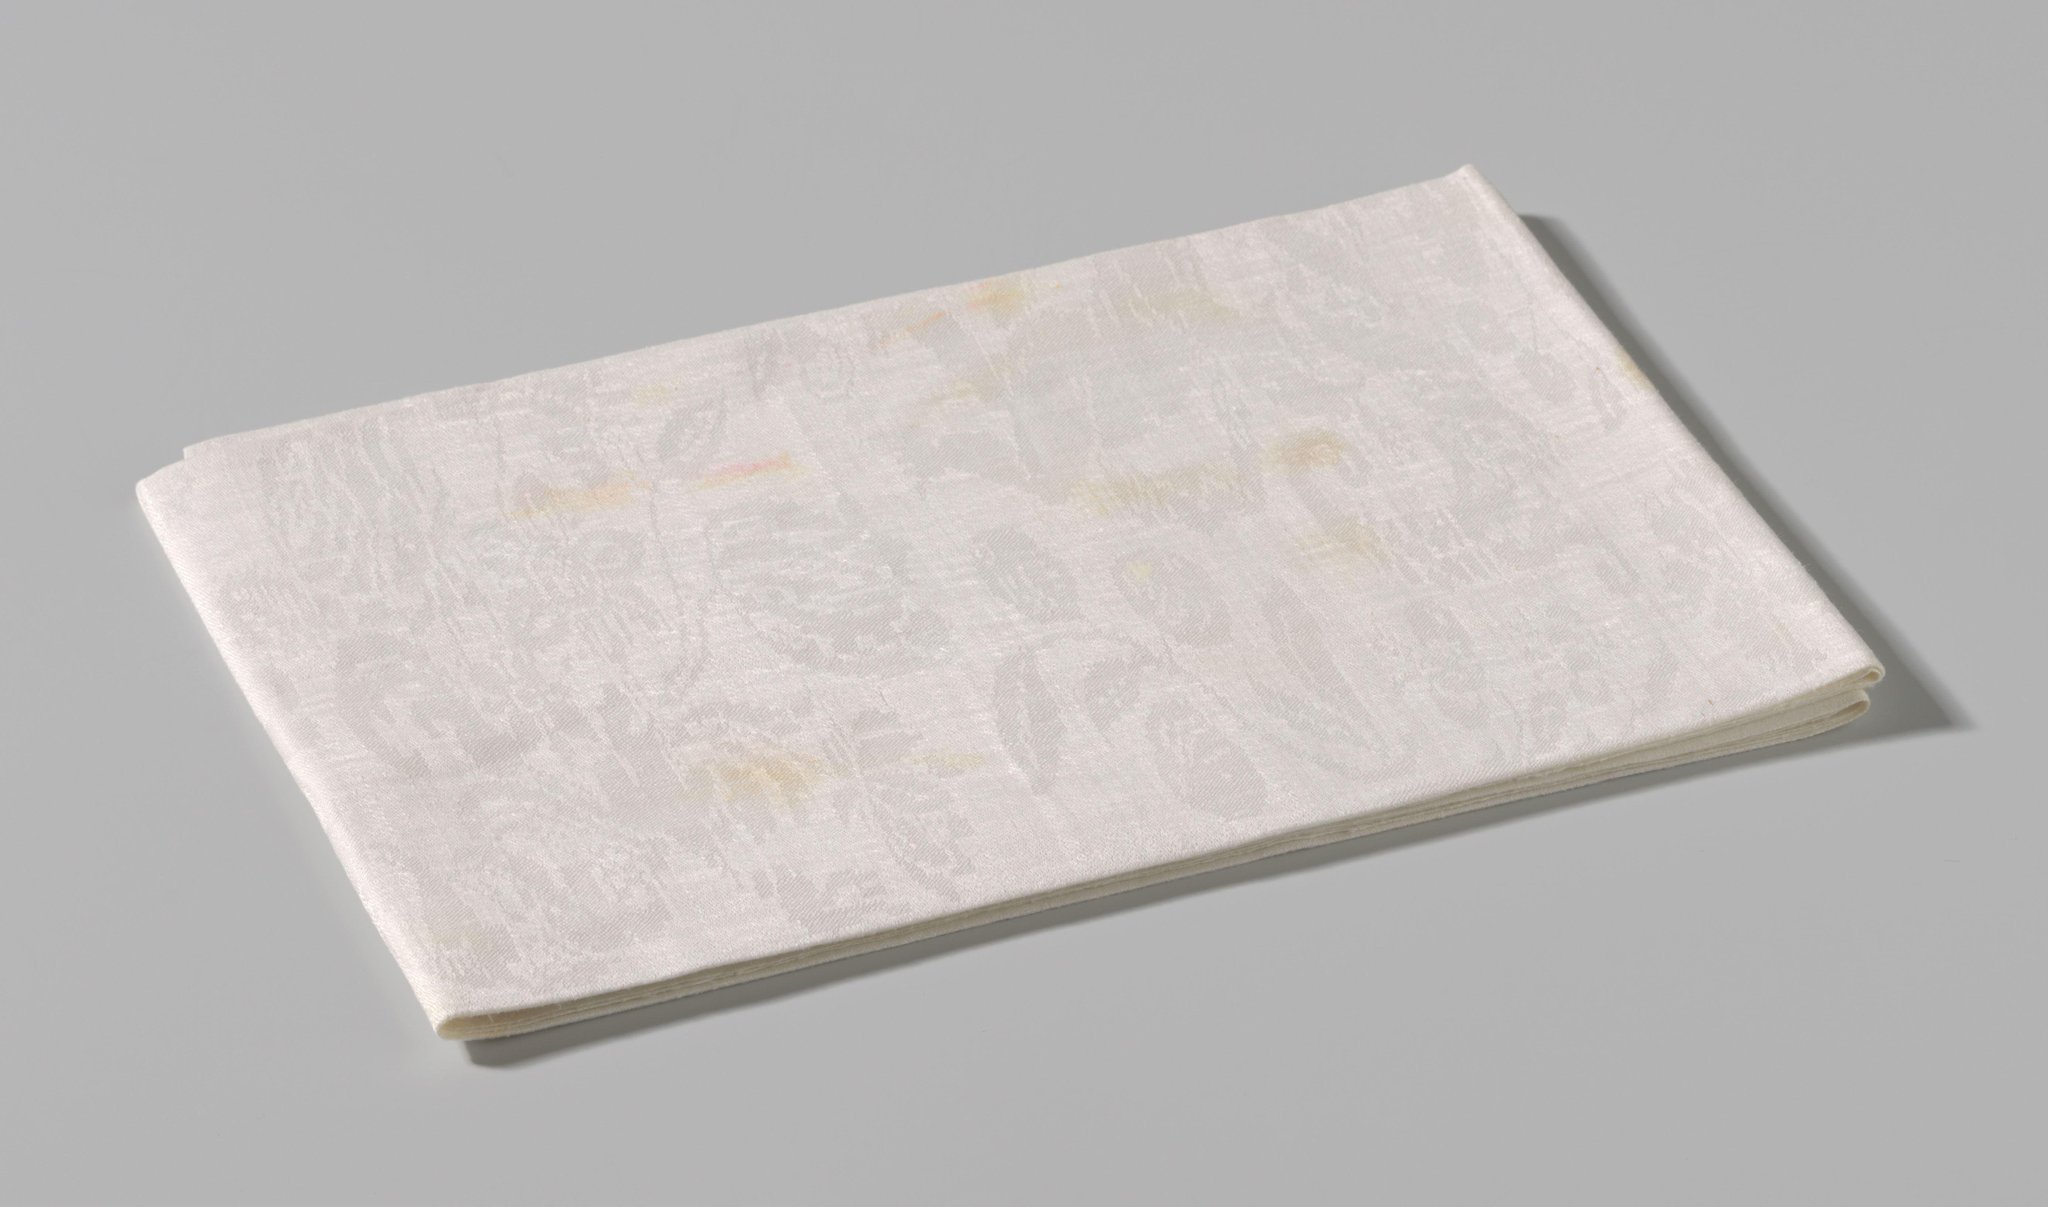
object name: napkin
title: Servet van linnendamast met putti en bloemen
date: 1660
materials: linen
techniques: damask, weave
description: Servet van linnendamast. Het patroon heeft bloemen en vruchten waartussen putti die hoorns des overvloed dragen en putti die een bloemenmand dragen. De lopende rand heeft een golvende lijn waartussen vogels en bloemen en een blokrand. Het servet is stukgoed, waardoor het geen liggende randen en hoeken heeft. Het servet hoort bij een tafellaken (BK-KOG-2607-A).